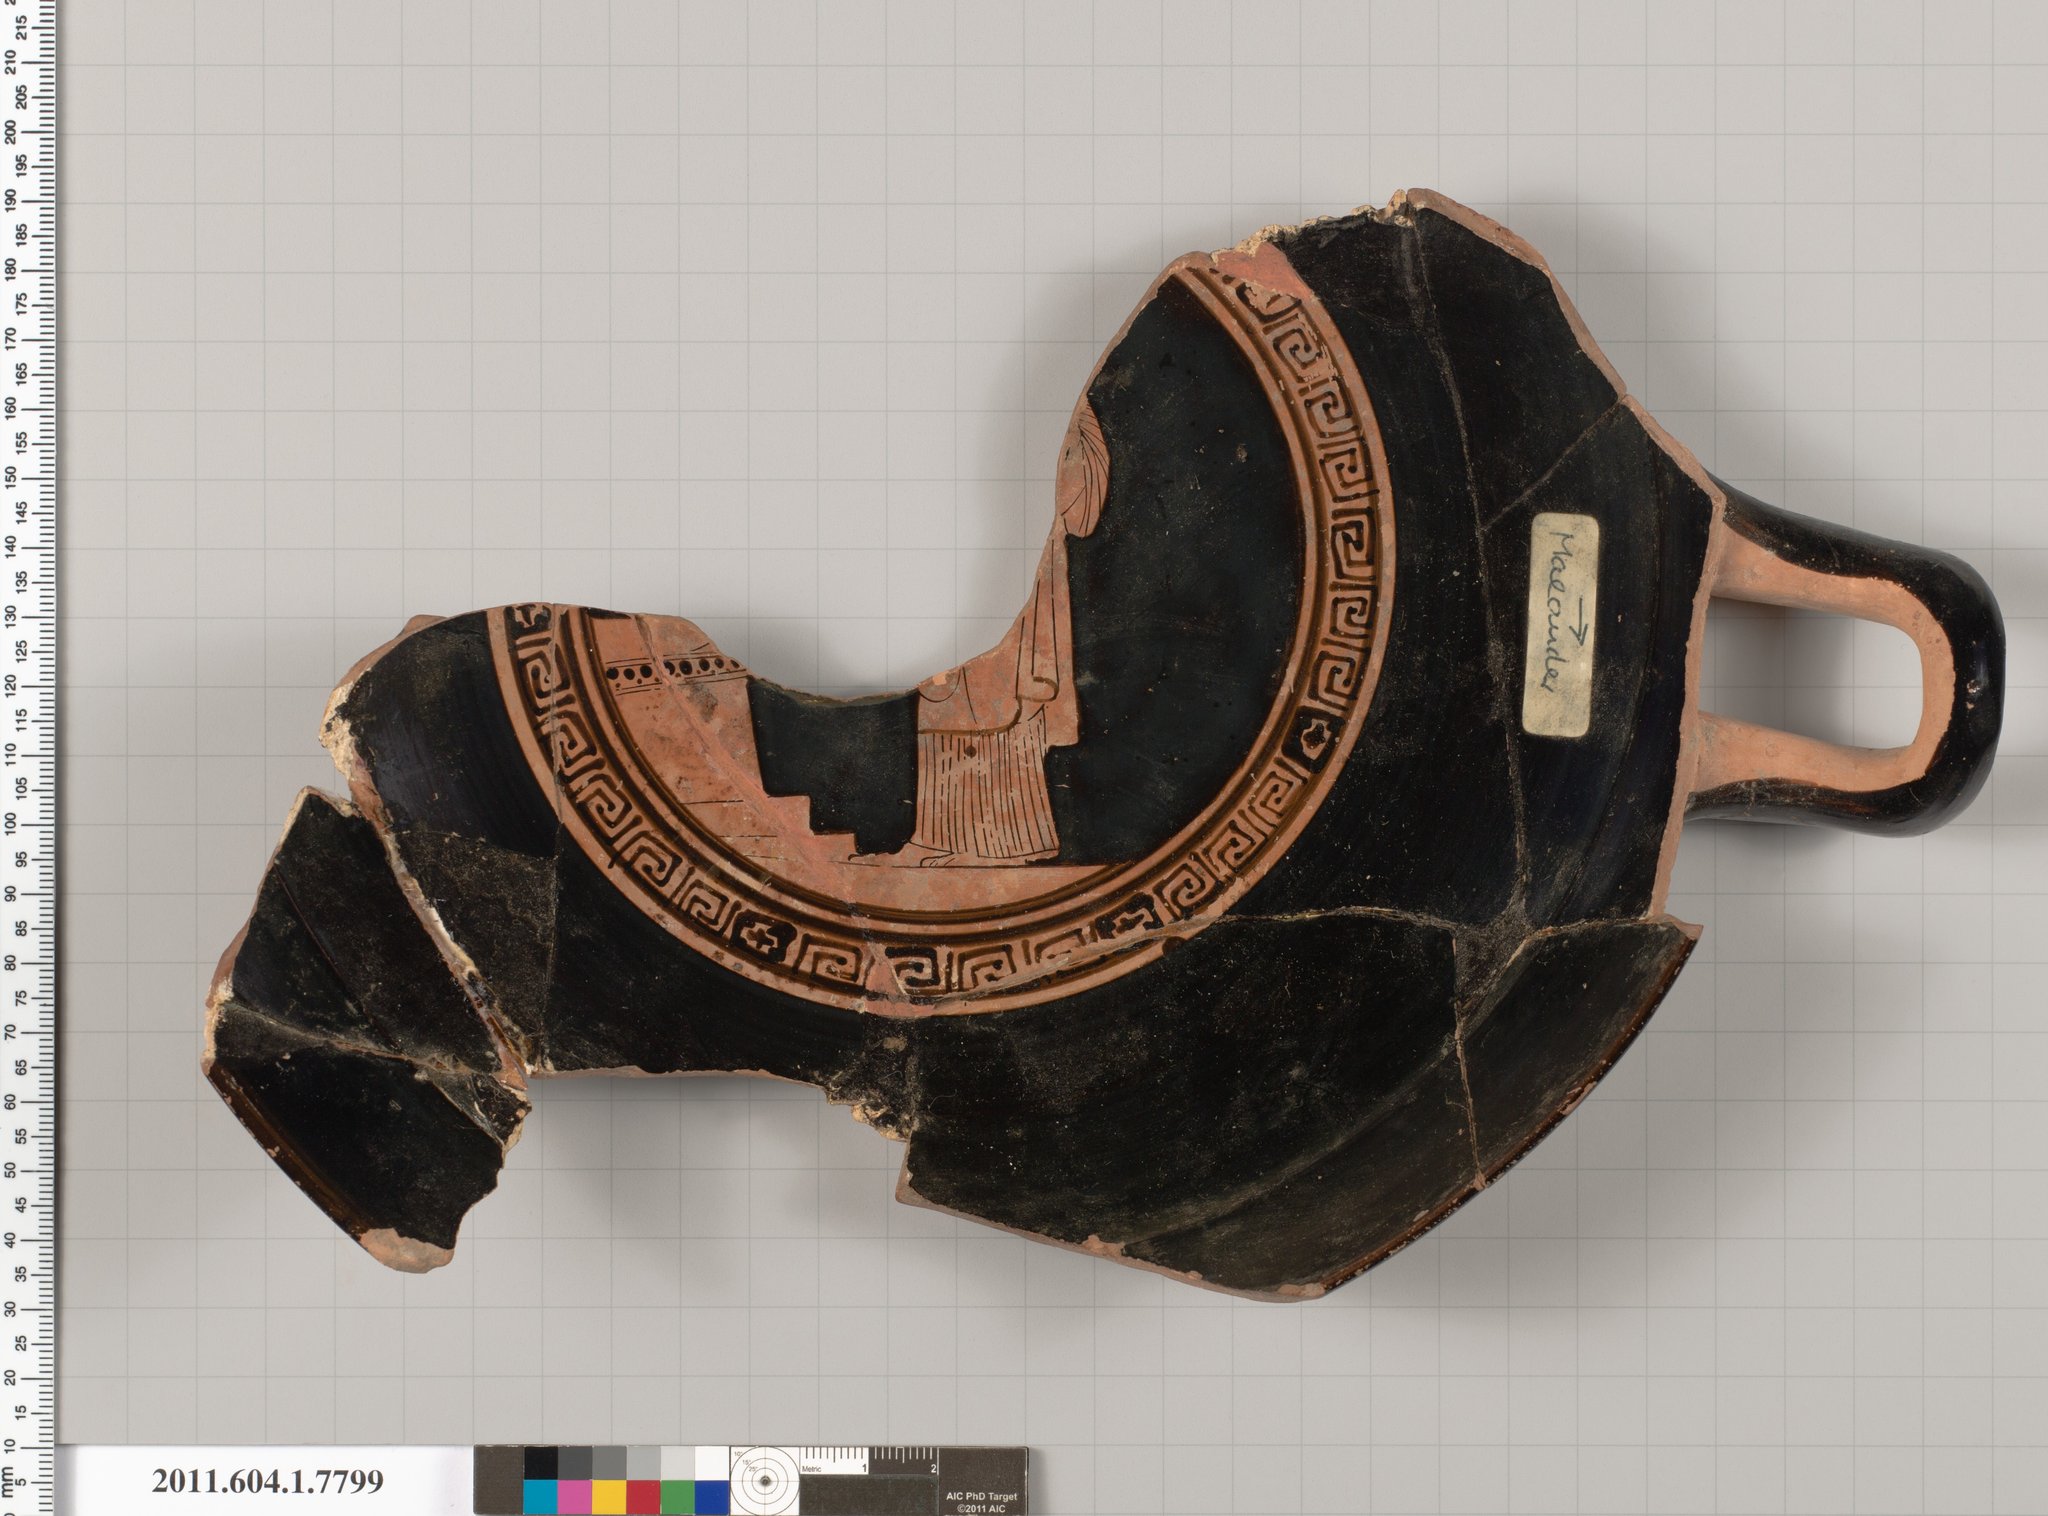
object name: kylix fragment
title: Terracotta fragment of a kylix (drinking cup)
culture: greek, attic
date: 460-450 BCE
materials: terracotta